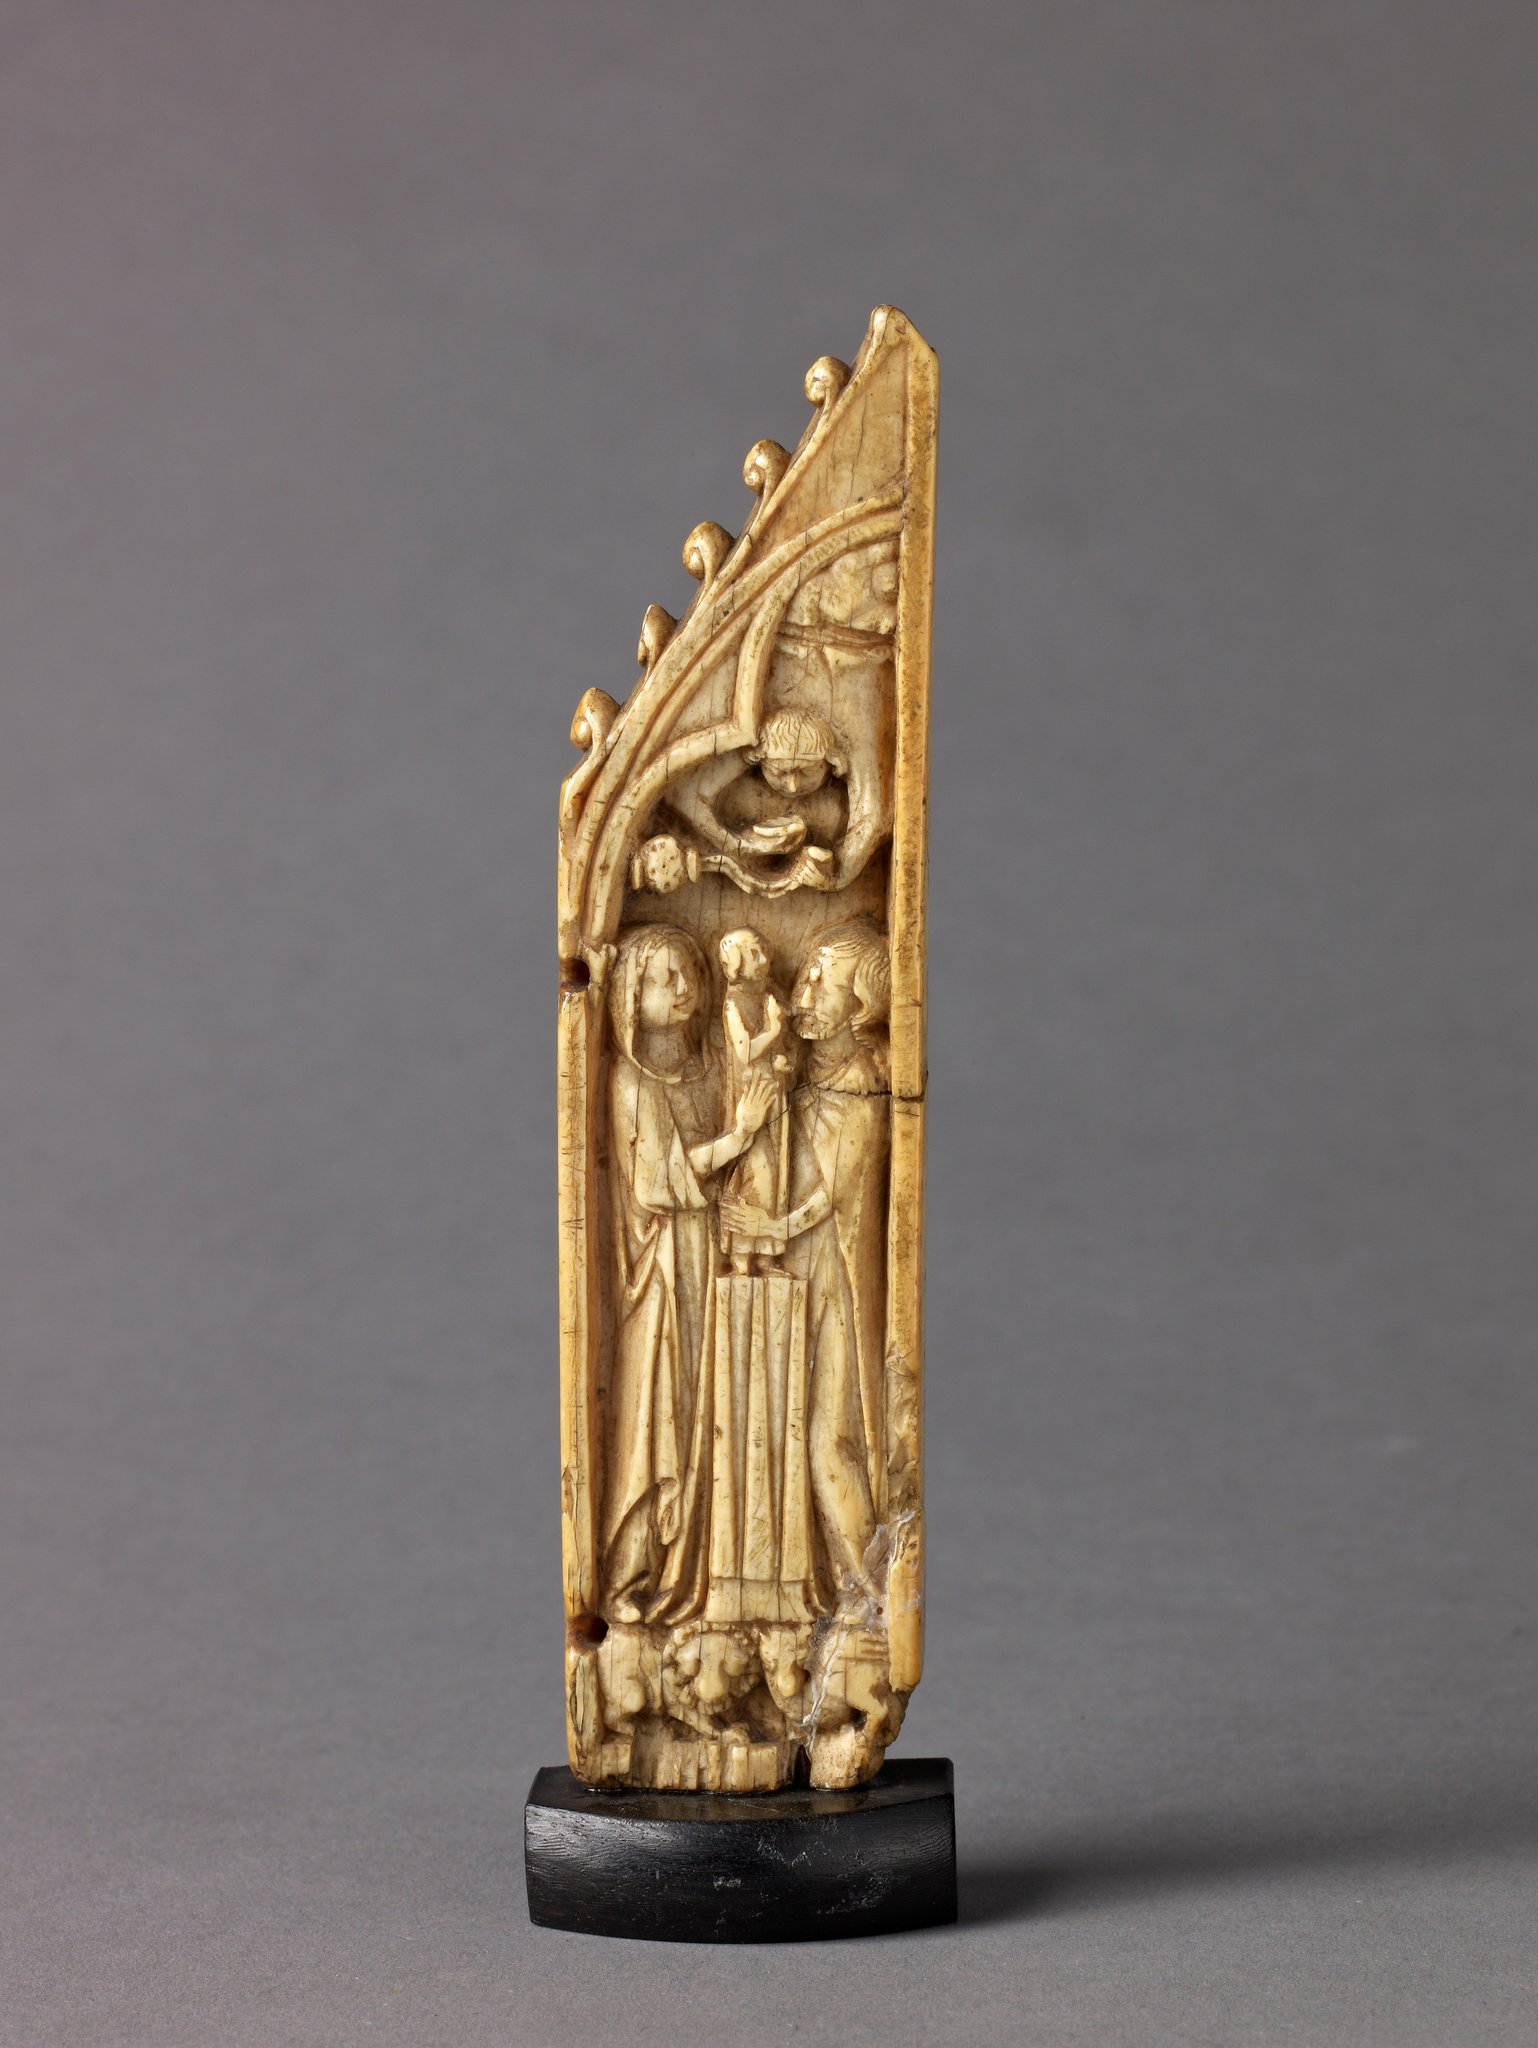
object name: triptych panel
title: Wing of a Polyptych: Presentation in the Temple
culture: northeastern french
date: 1325-1350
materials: ivory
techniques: polychromy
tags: angels,virgin mary,jesus